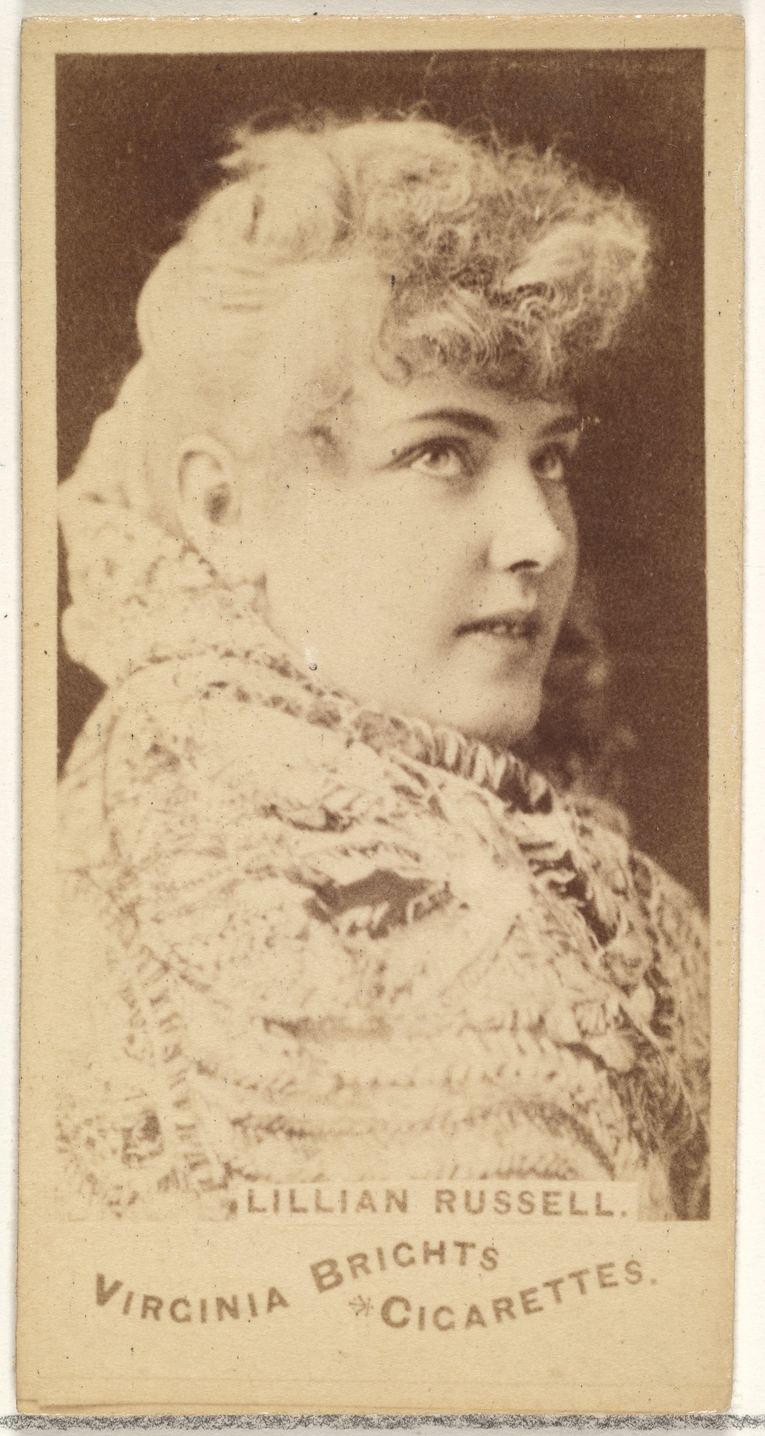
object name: photograph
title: Lillian Russell, from the Actors and Actresses series (N45, Type 1) for Virginia Brights Cigarettes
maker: allen & ginter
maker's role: publisher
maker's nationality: american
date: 1888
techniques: albumen silver print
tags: portraits,women,actresses